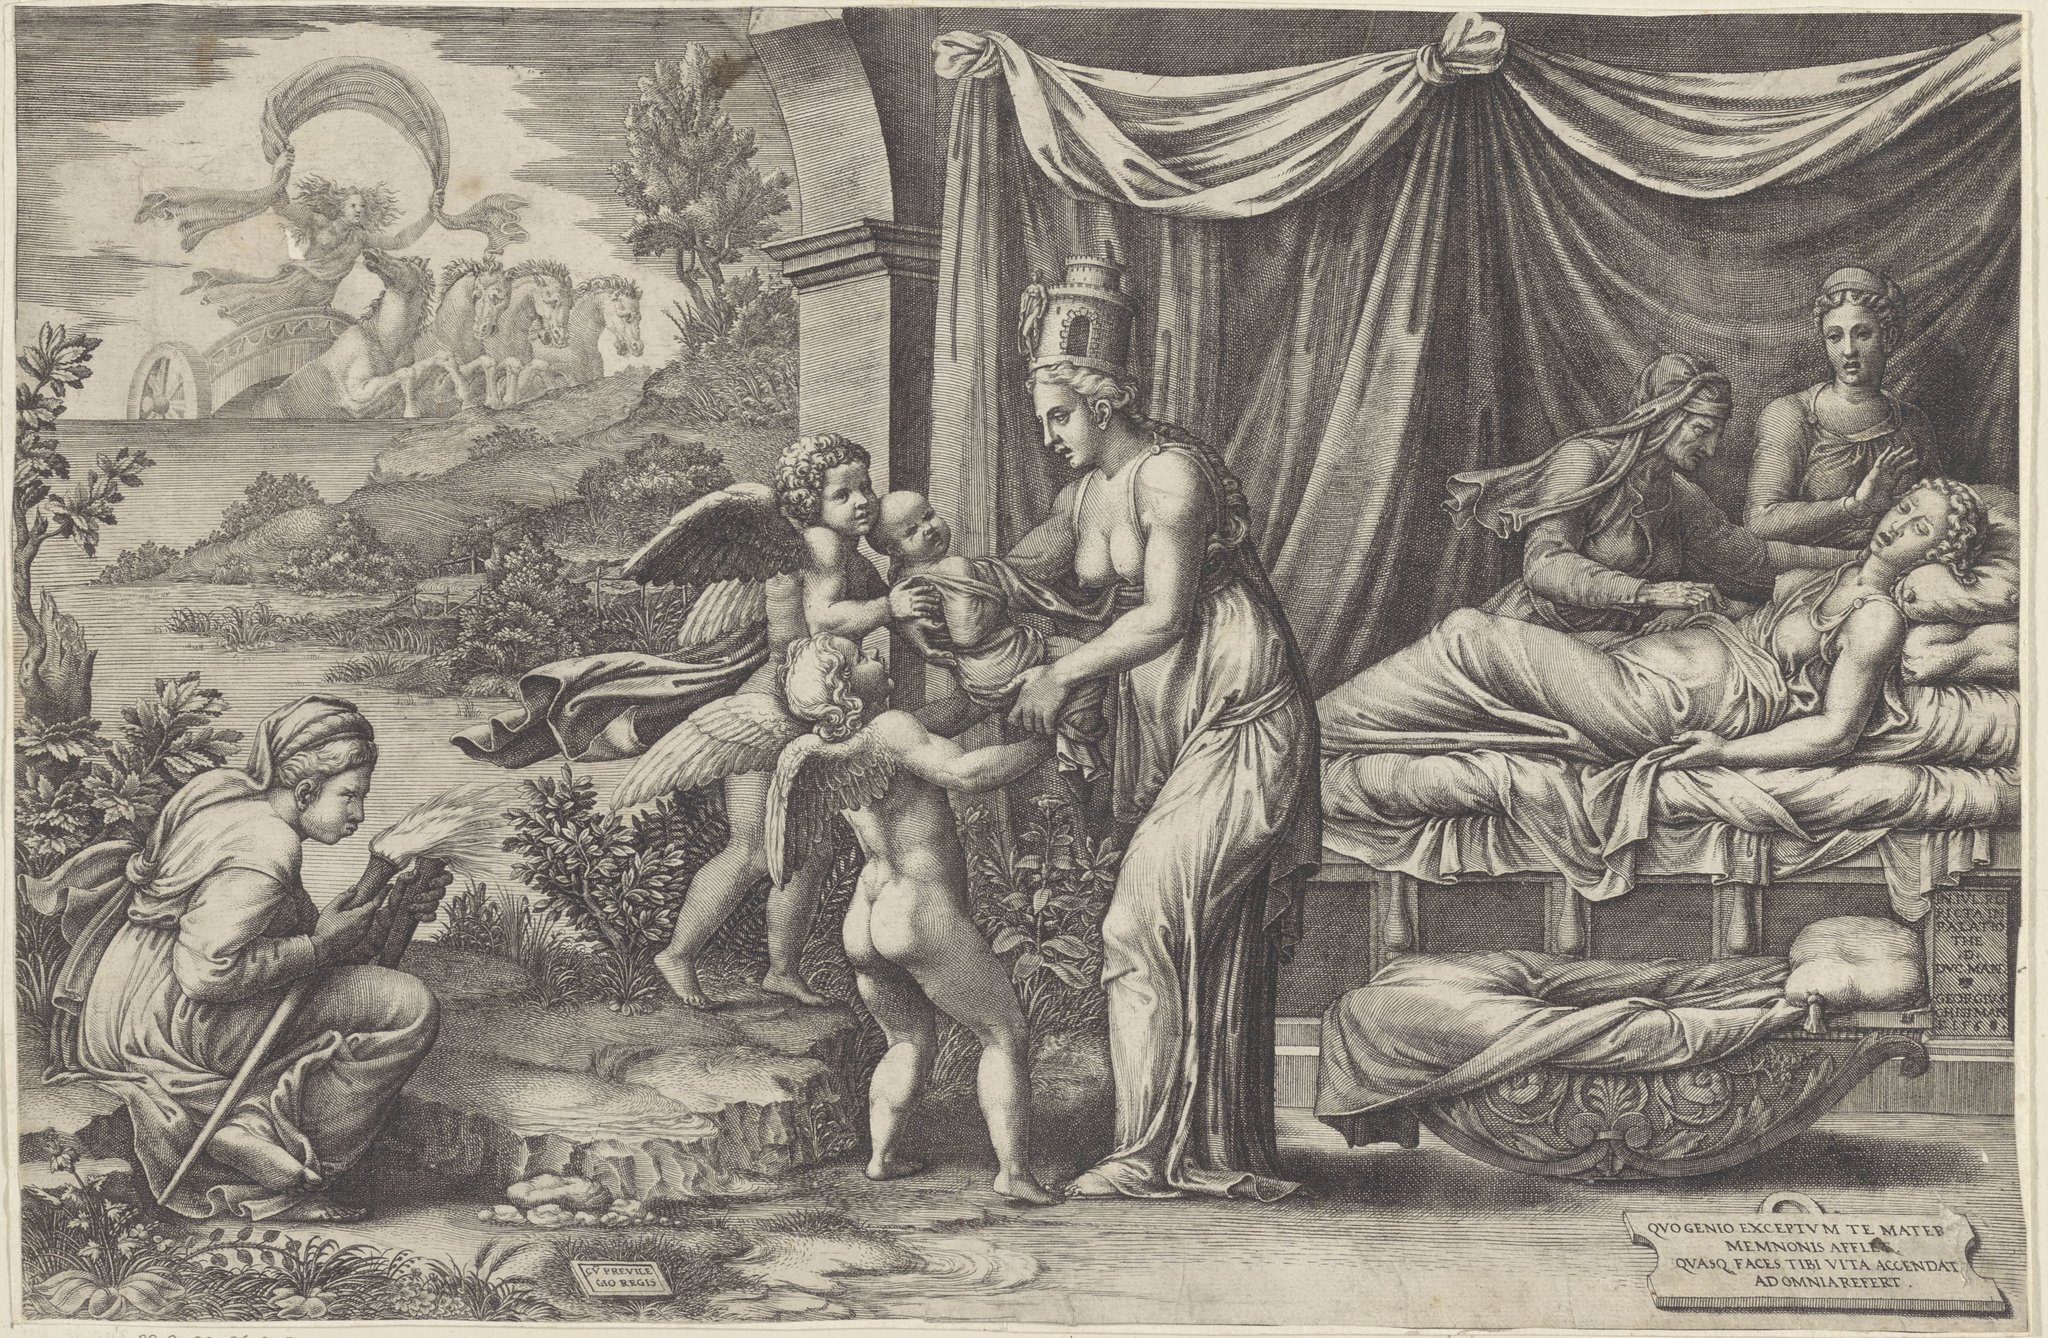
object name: print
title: Allegorie op de Geboorte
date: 1560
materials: paper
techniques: engraving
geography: italy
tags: apollo as sun-god, i.e. sol (helius), titan, woman giving birth (lying-in), cupids: 'amores', 'amoretti', 'putti'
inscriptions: collector's mark: Lugt 240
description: Een vrouw geeft een pasgeboren baby aan twee putti. Links zit een vrouw met een brandende fakkel. Rechts ligt een vrouw die zojuist is bevallen. Naast het bed staan twee vrouwen. Op de achtergrond Apollo op zijn zonnewagen.